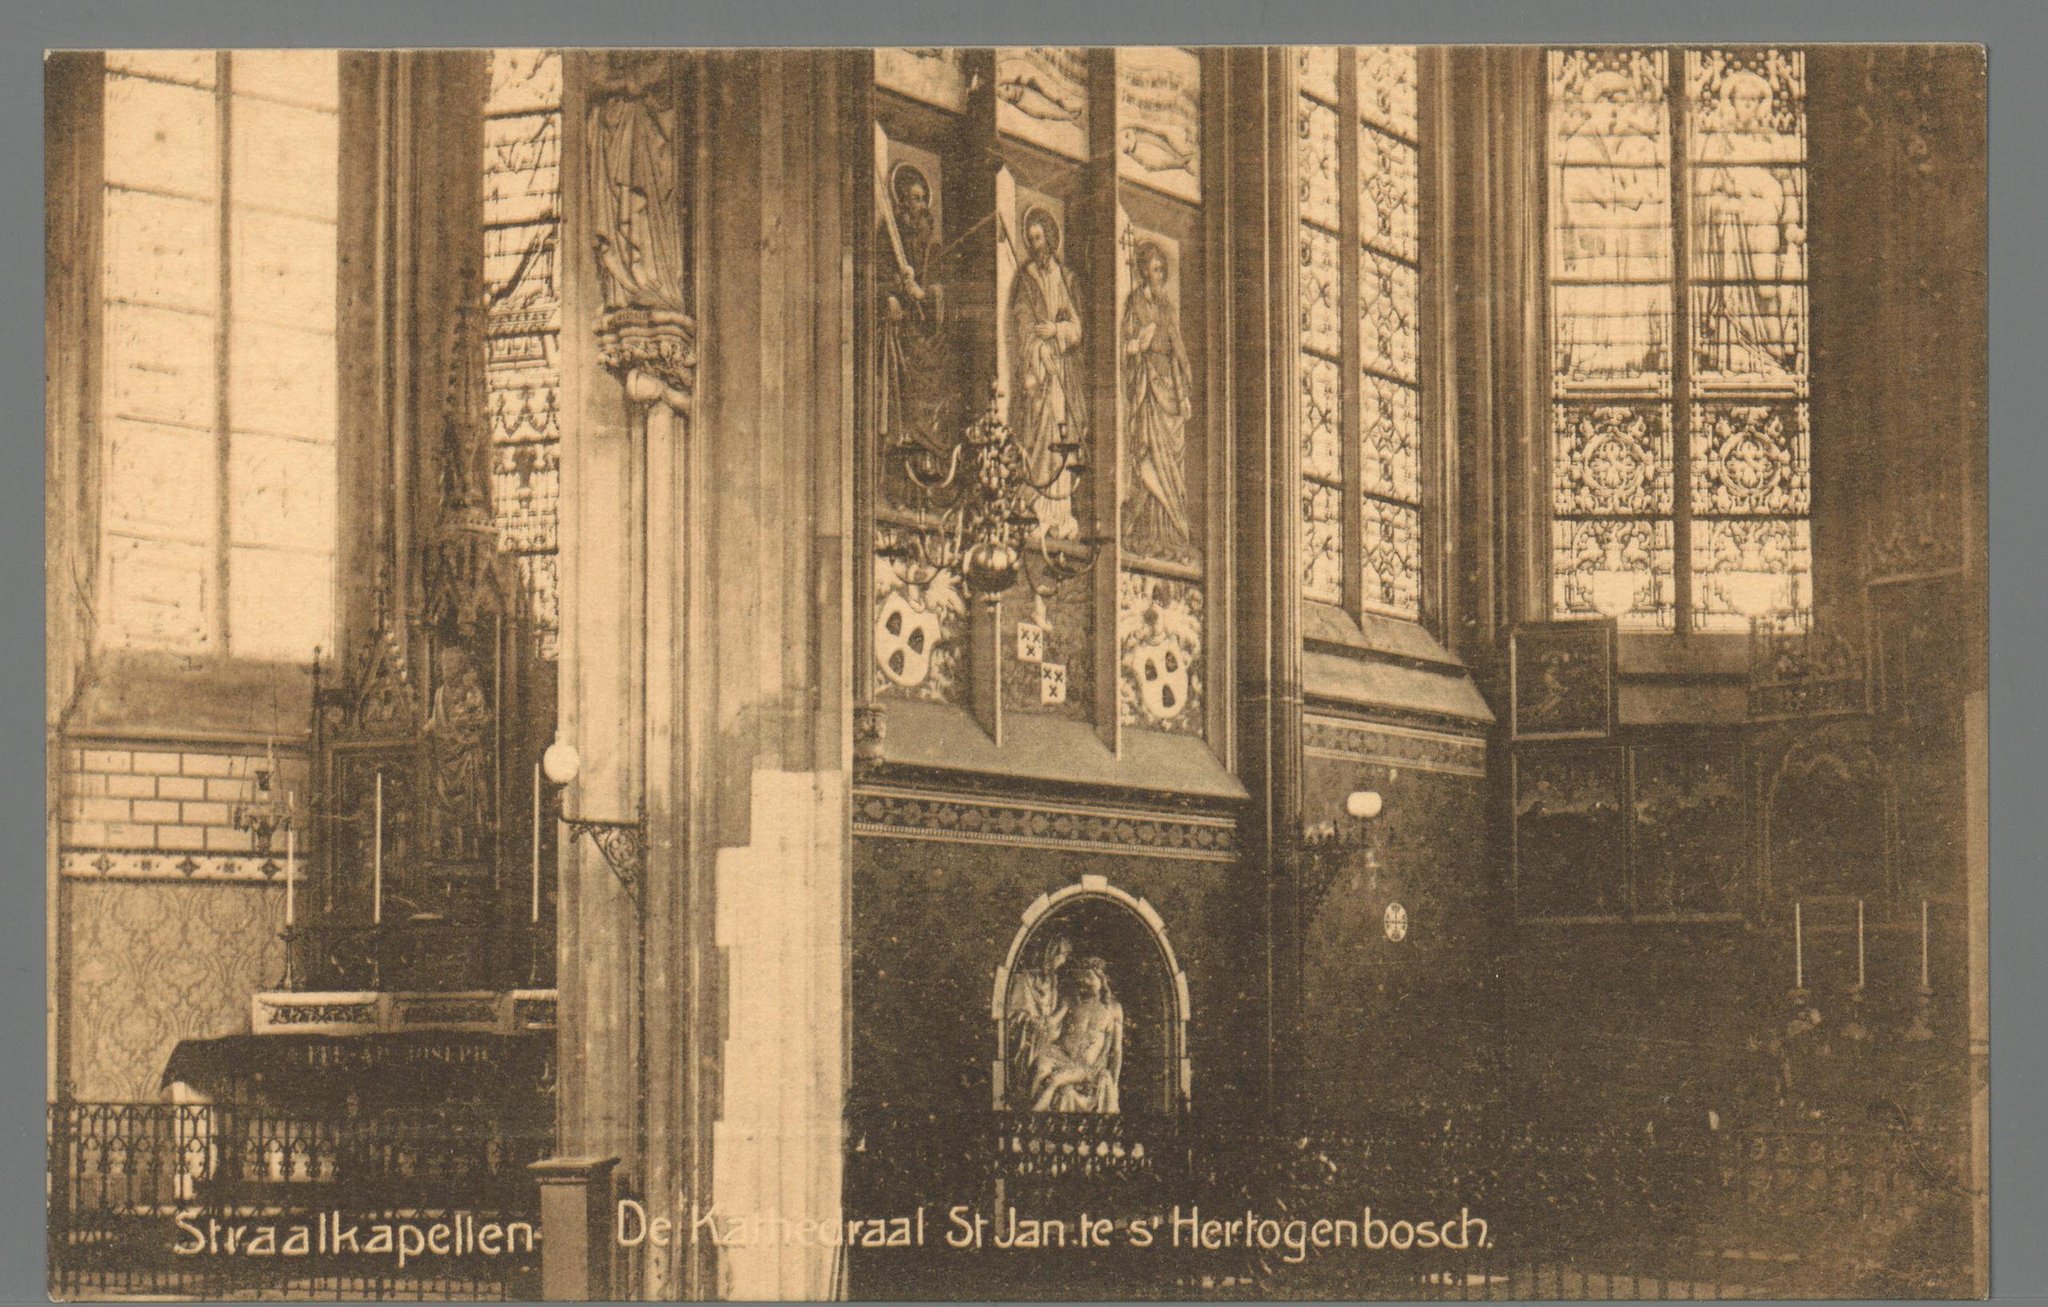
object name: ansichtkaart, prentbriefkaart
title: De Kathedraal St Jan te s' Hertogenbosch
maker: Anonymous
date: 1905-1930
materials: cardboard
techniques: photograph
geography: den bosch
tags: parts of church interior: chapel